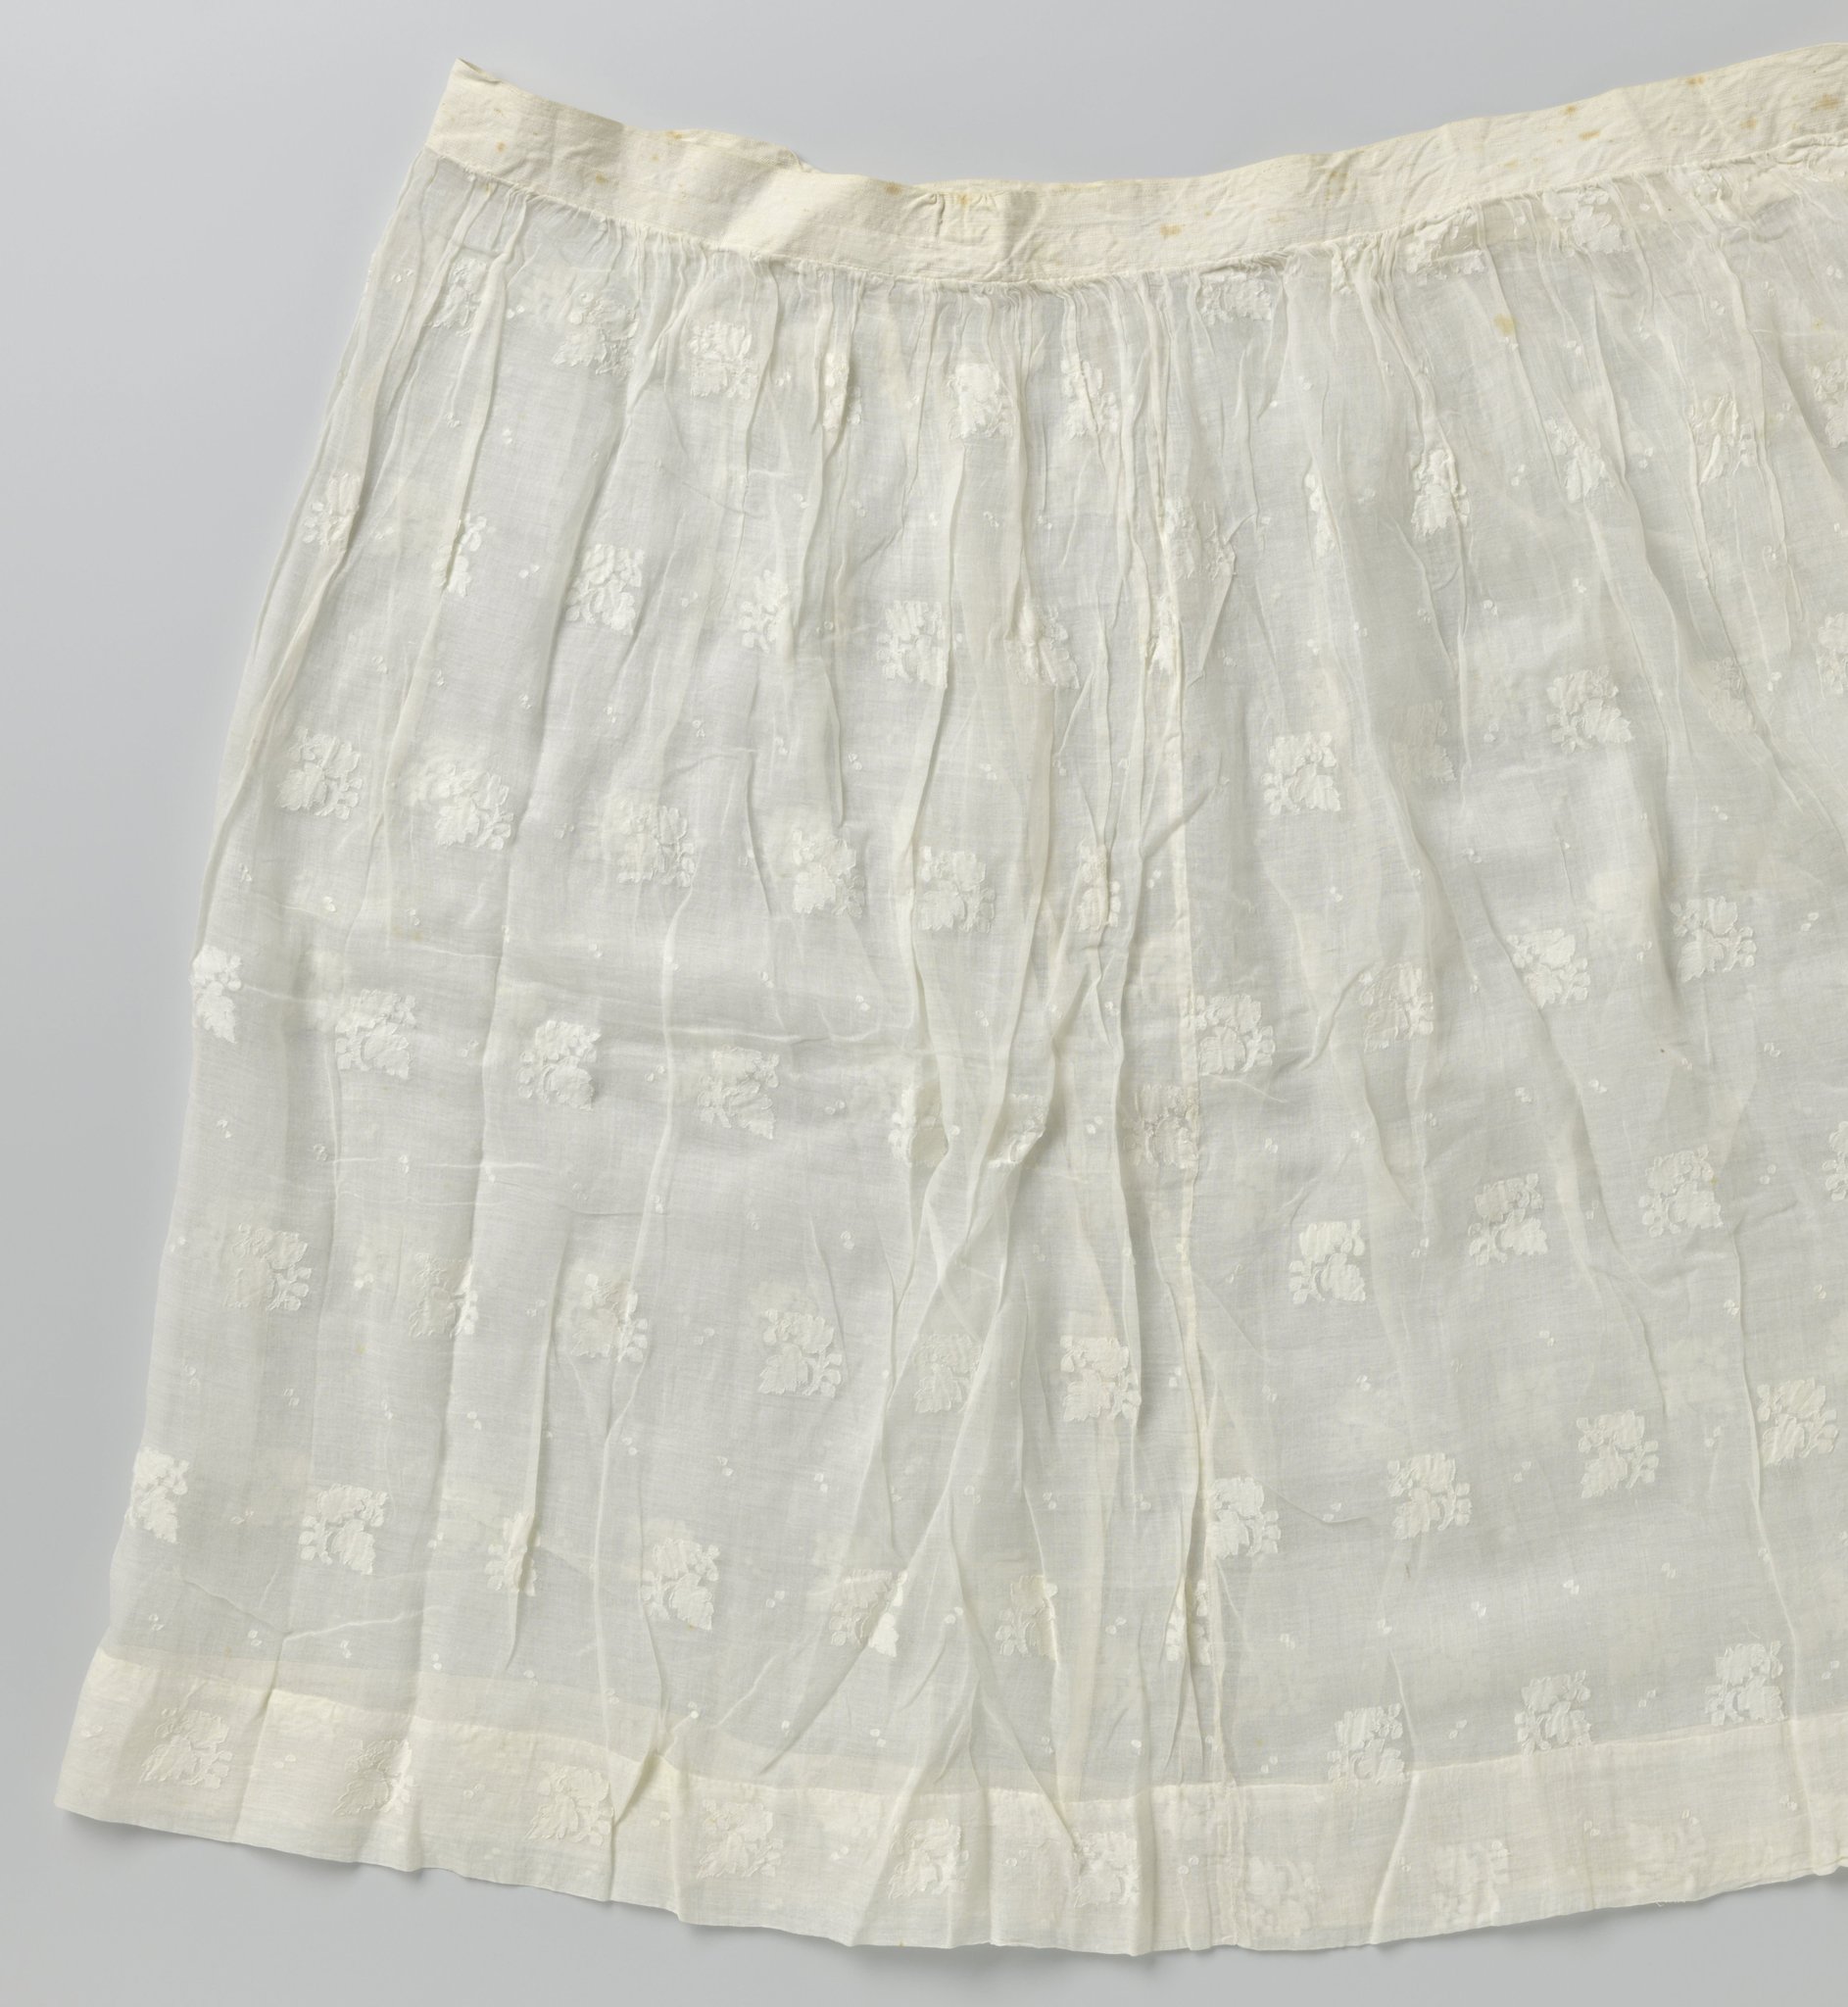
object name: val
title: Val van batist voor een toilettafel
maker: Anonymous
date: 1800-1920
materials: textile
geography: netherlands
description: Batisten val voor een toilettafel in een boudoir (inv.nr. BK 1980-789f).